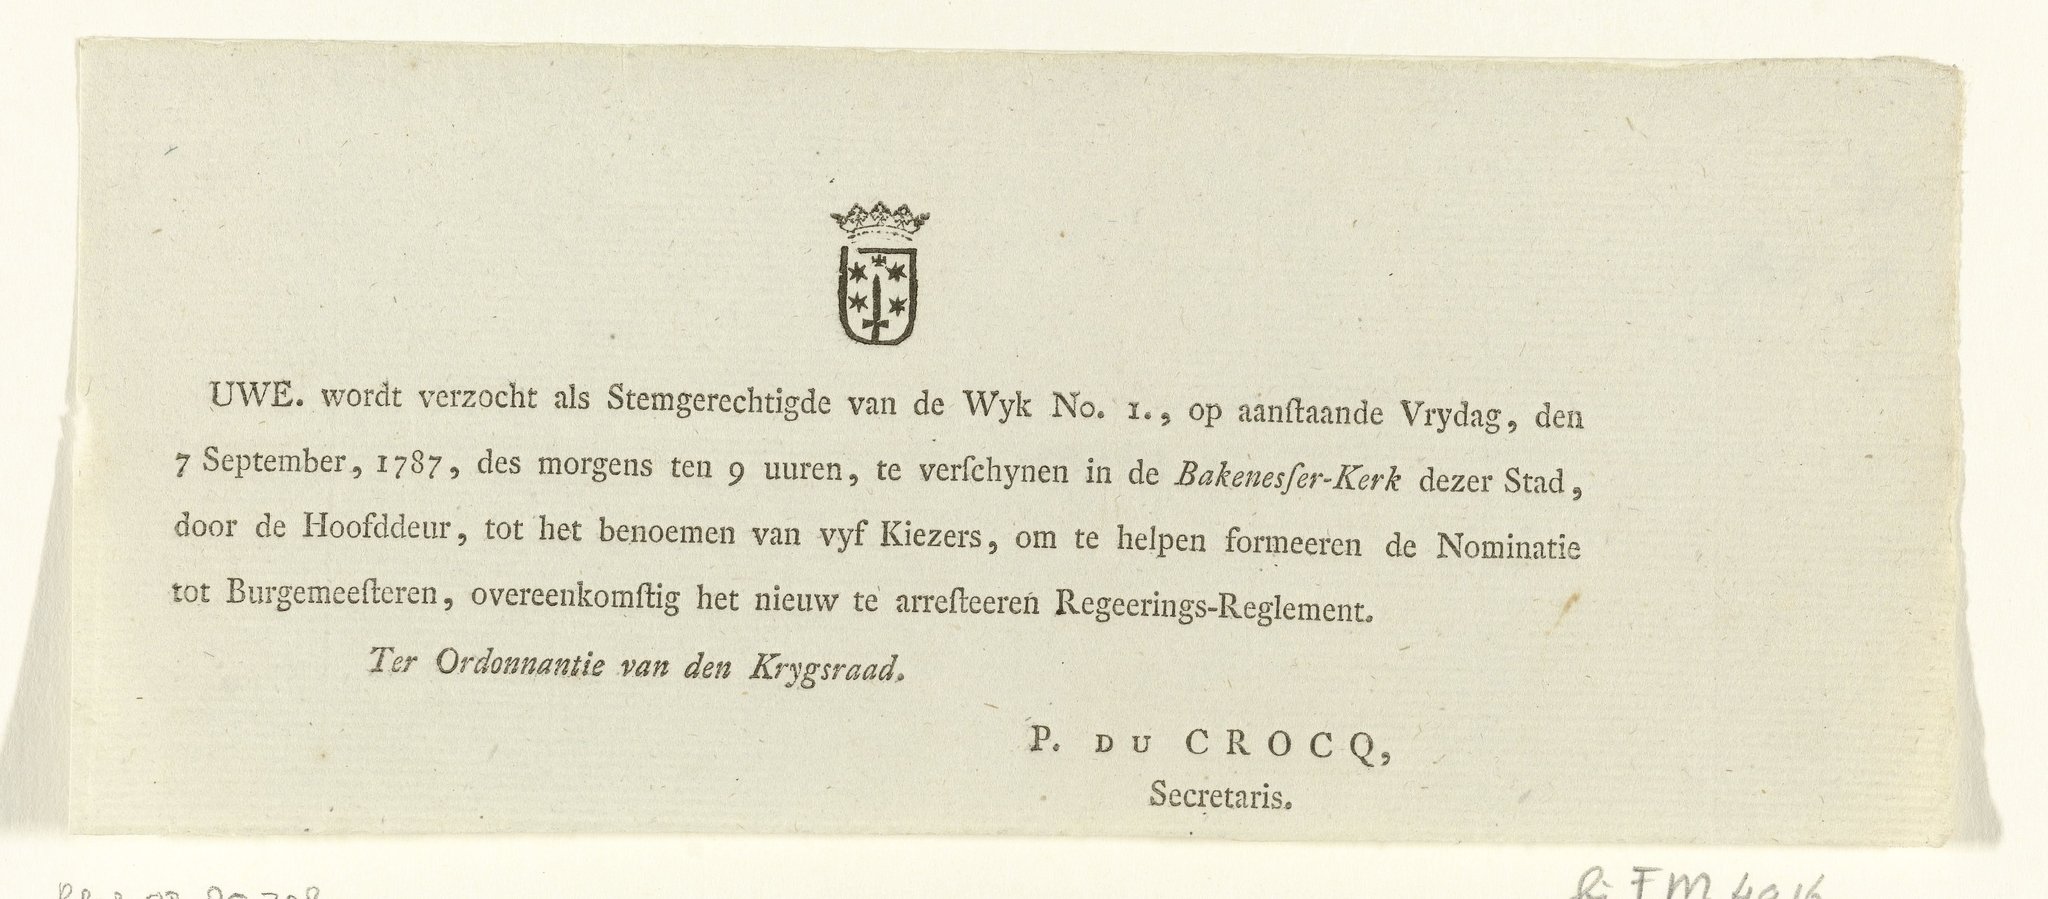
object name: text sheet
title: Oproep om te stemmen voor een kiescommissie in Haarlem, 1787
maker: Anonymous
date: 1787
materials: paper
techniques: letterpress printing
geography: haarlem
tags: haarlem, patriots (1780-1795)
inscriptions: collector's mark: Lugt 2228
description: Tekstblad met een oproep om op 7 september in de Bakenesserkerk te stemmen voor een kiescommissie die de nieuwe burgemeesters in Haarlem zal benoemen, overeenkomstig het nieuwe regeringsreglement. Bovenaan het stadswapen van Haarlem. Onderaan de naam van secretaris P. du Crocq.